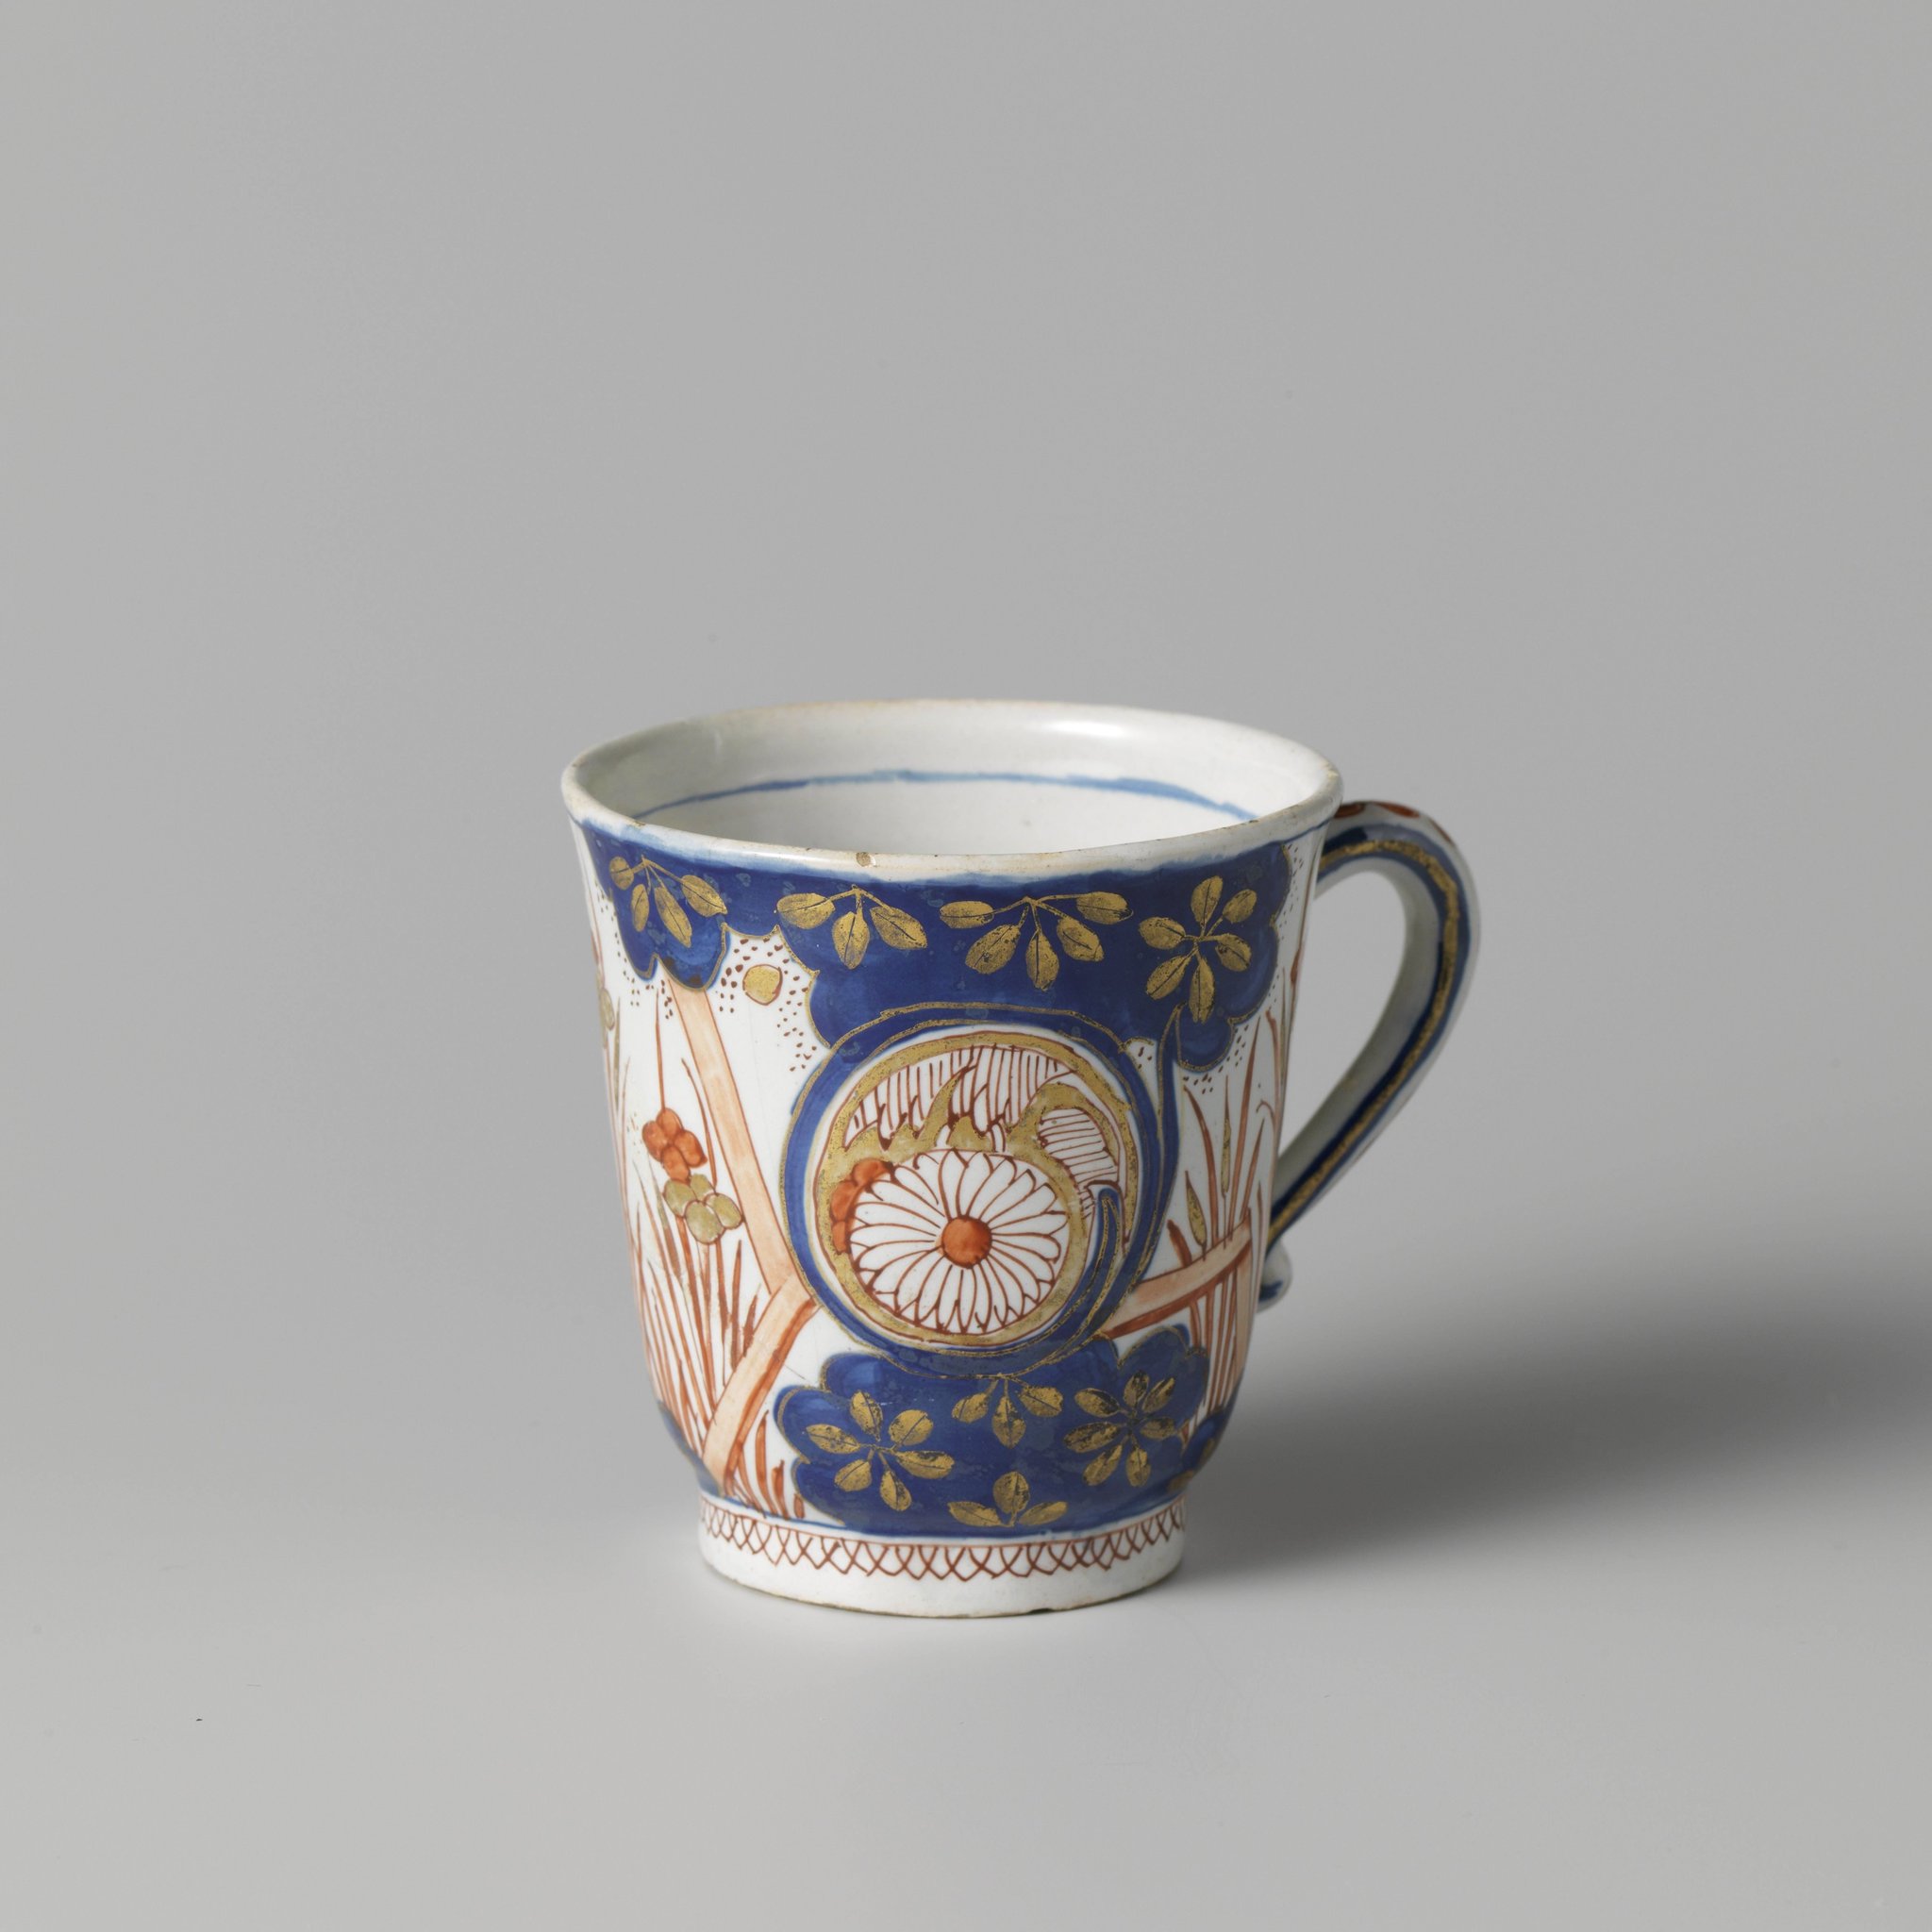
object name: cup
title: Kop van faience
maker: pieter adriaensz. kocx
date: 1700-1725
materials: faience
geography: delft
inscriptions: mark: ‘APK (ineen)/ 78/ 87’, inscription: ‘A'dam/ RM 16’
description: Kop van faience, veelkleurig beschilderd met bloem- en bladdecoratie.